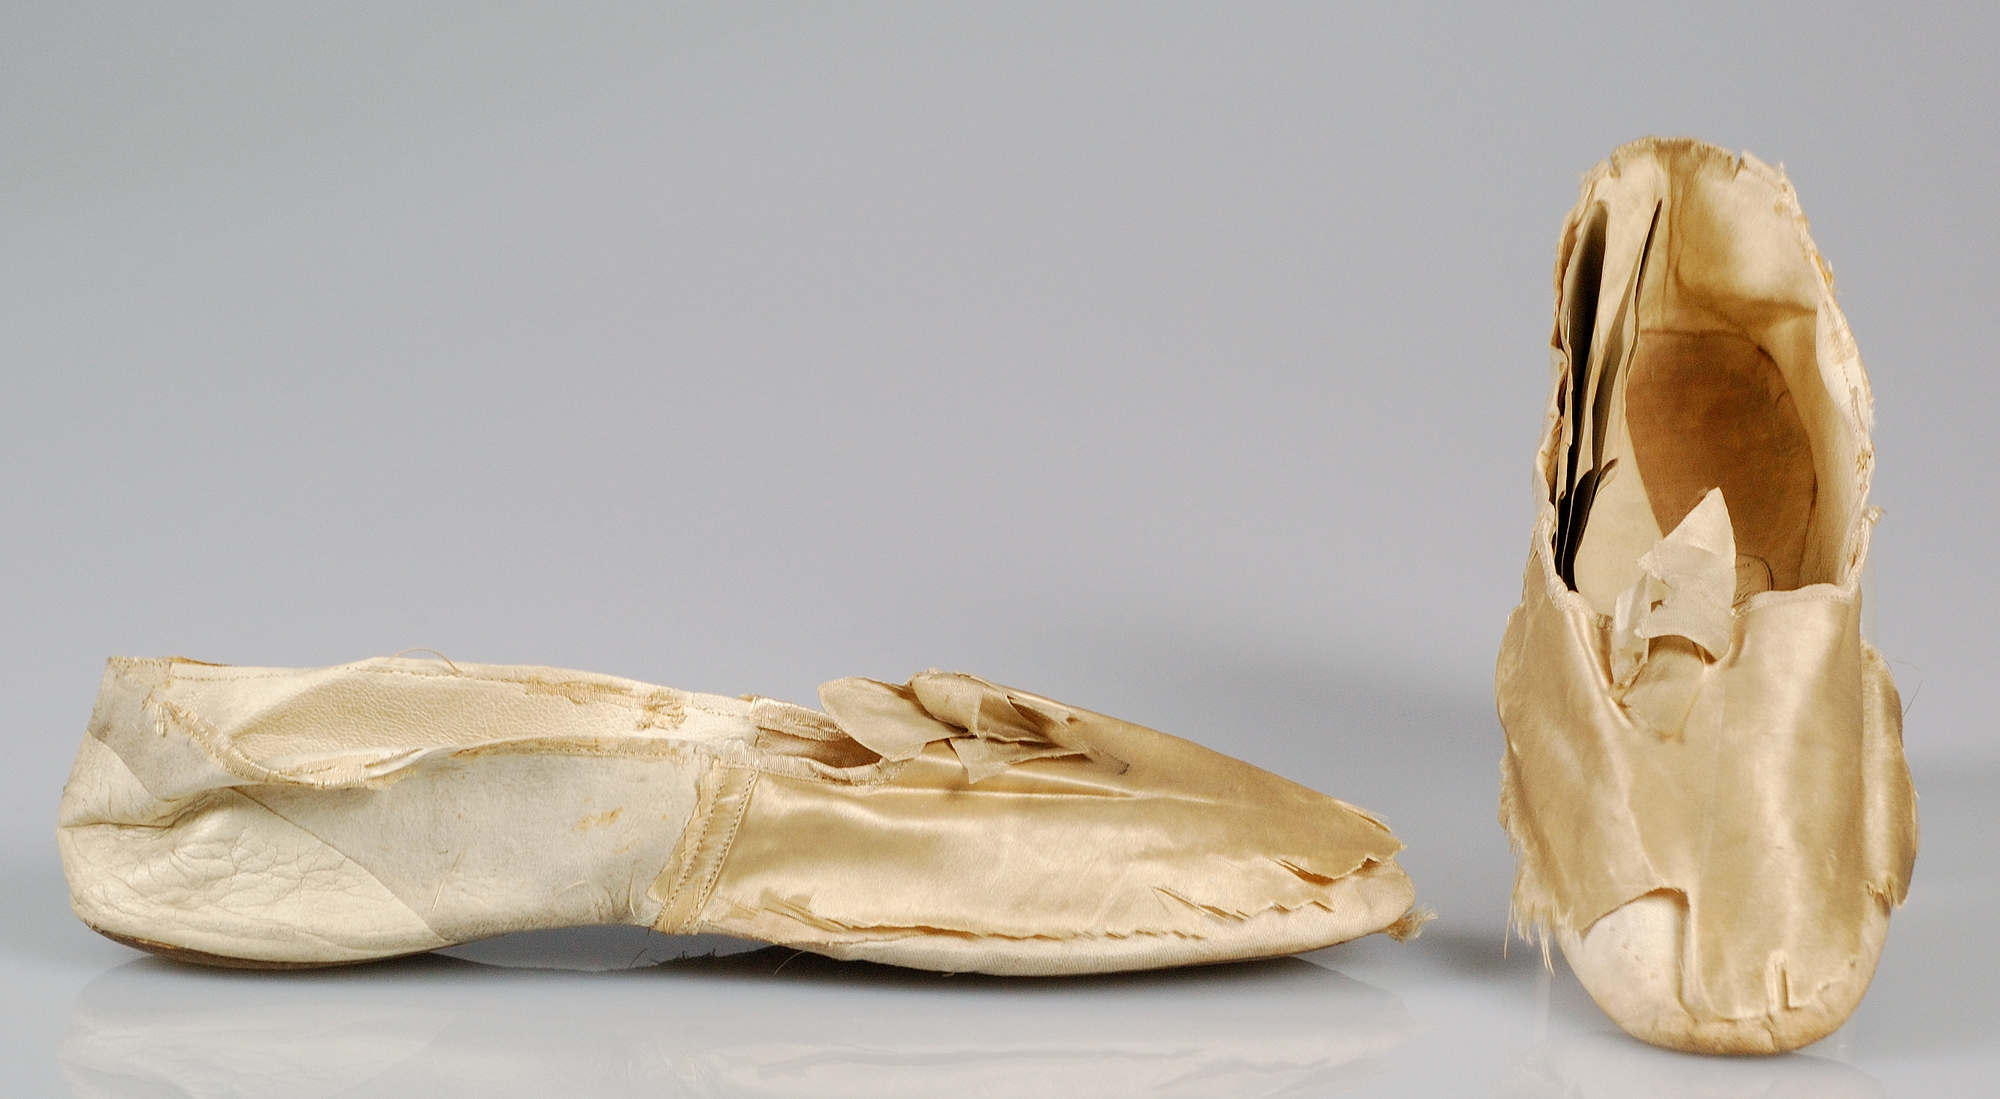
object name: evening slipper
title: Evening slippers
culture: british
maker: despa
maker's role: maker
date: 1815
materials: silk